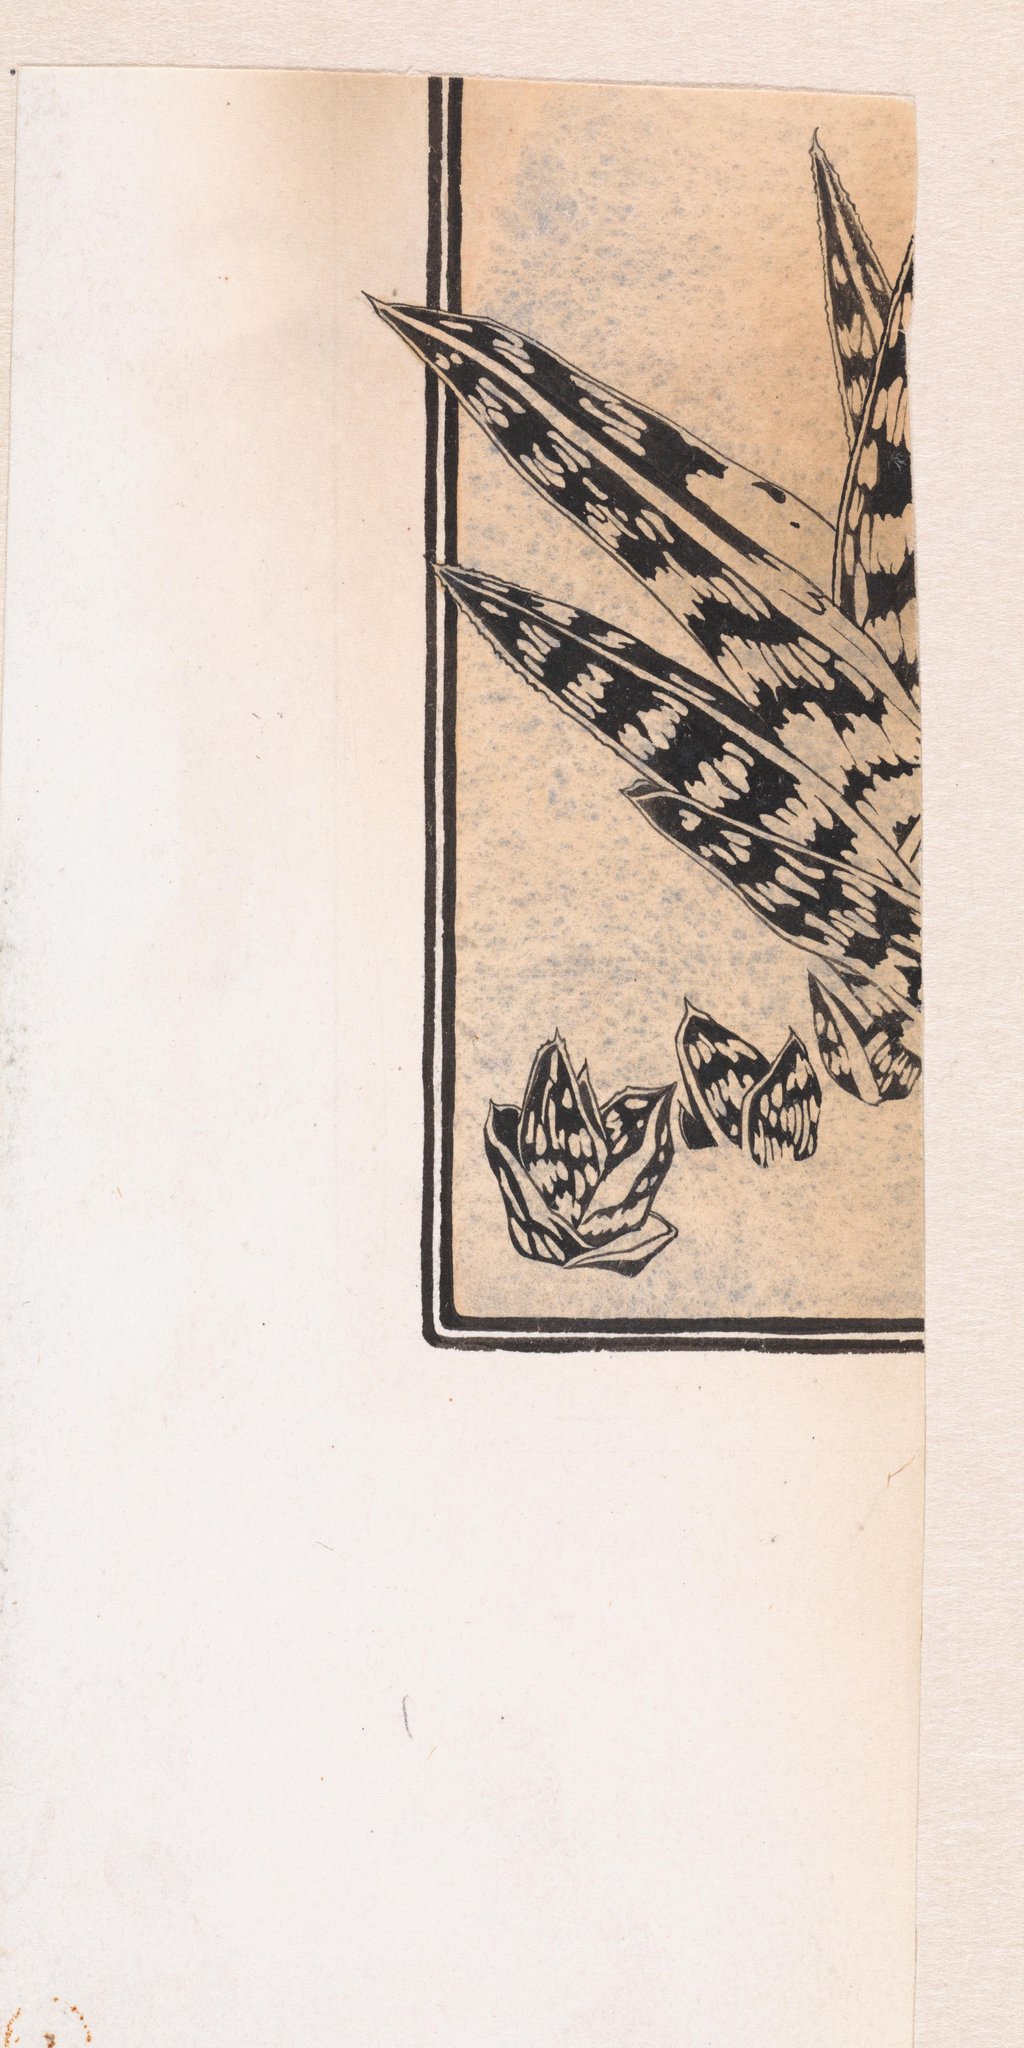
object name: drawing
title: Fragment van een studie van een vetplant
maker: julie de graag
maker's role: draughtsman, print maker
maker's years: 1877-1924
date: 1887-1924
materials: ink, paper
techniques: brush, pen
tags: plants and herbs: succulent